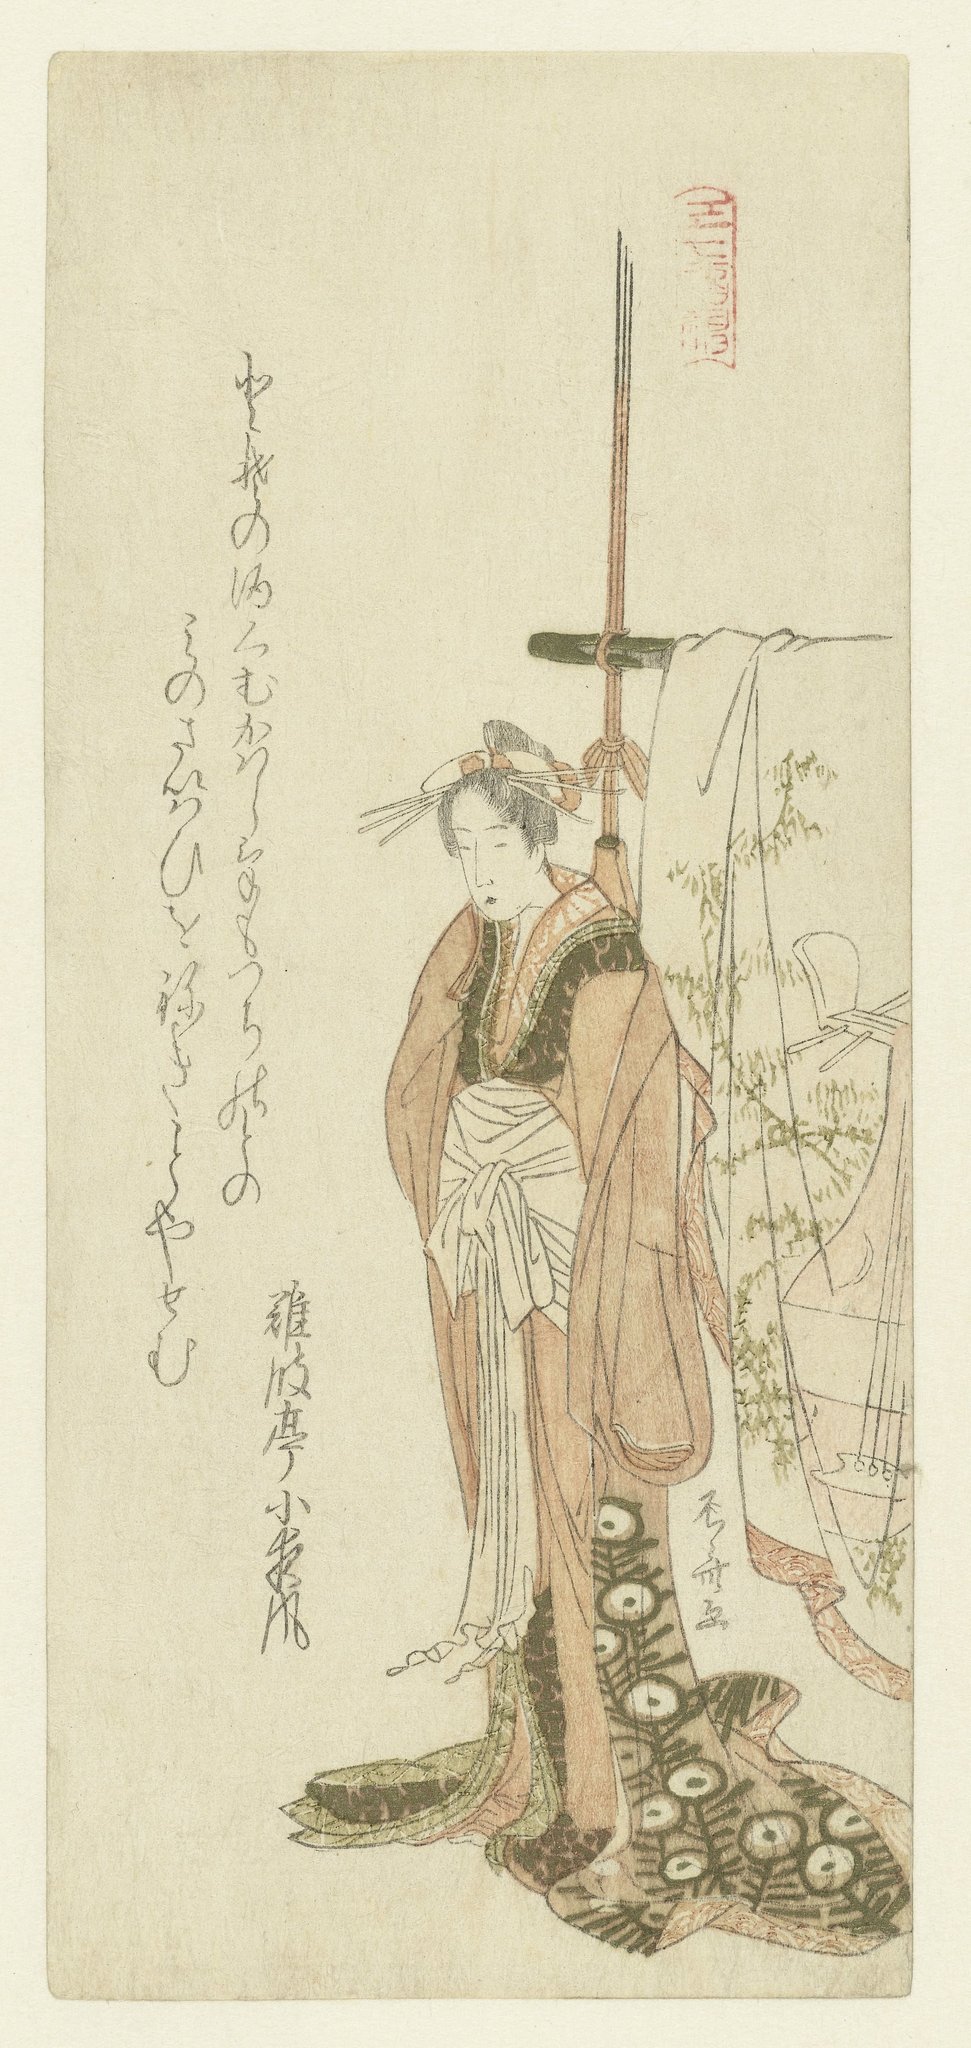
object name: print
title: Courtesan Standing by a Kimono on a Rack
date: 1809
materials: paper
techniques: blind stamped, woodcut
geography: japan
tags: courtesan, hetaera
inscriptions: collector's mark, verso, stamped: Lugt 1172c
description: Een surimono is een luxe uitgevoerde prent waarop beeld met één of meerdere gedichten gecombineerd is. Bij het drukken van een surimono werd vaak gebruik gemaakt van dikker papier, blinddruk en metaal pigmenten, zoals koper- en zilverpoeder. De prenten werden vaak in opdracht van dichters gemaakt en als exclusief geschenk aan vrienden en relaties gegeven.